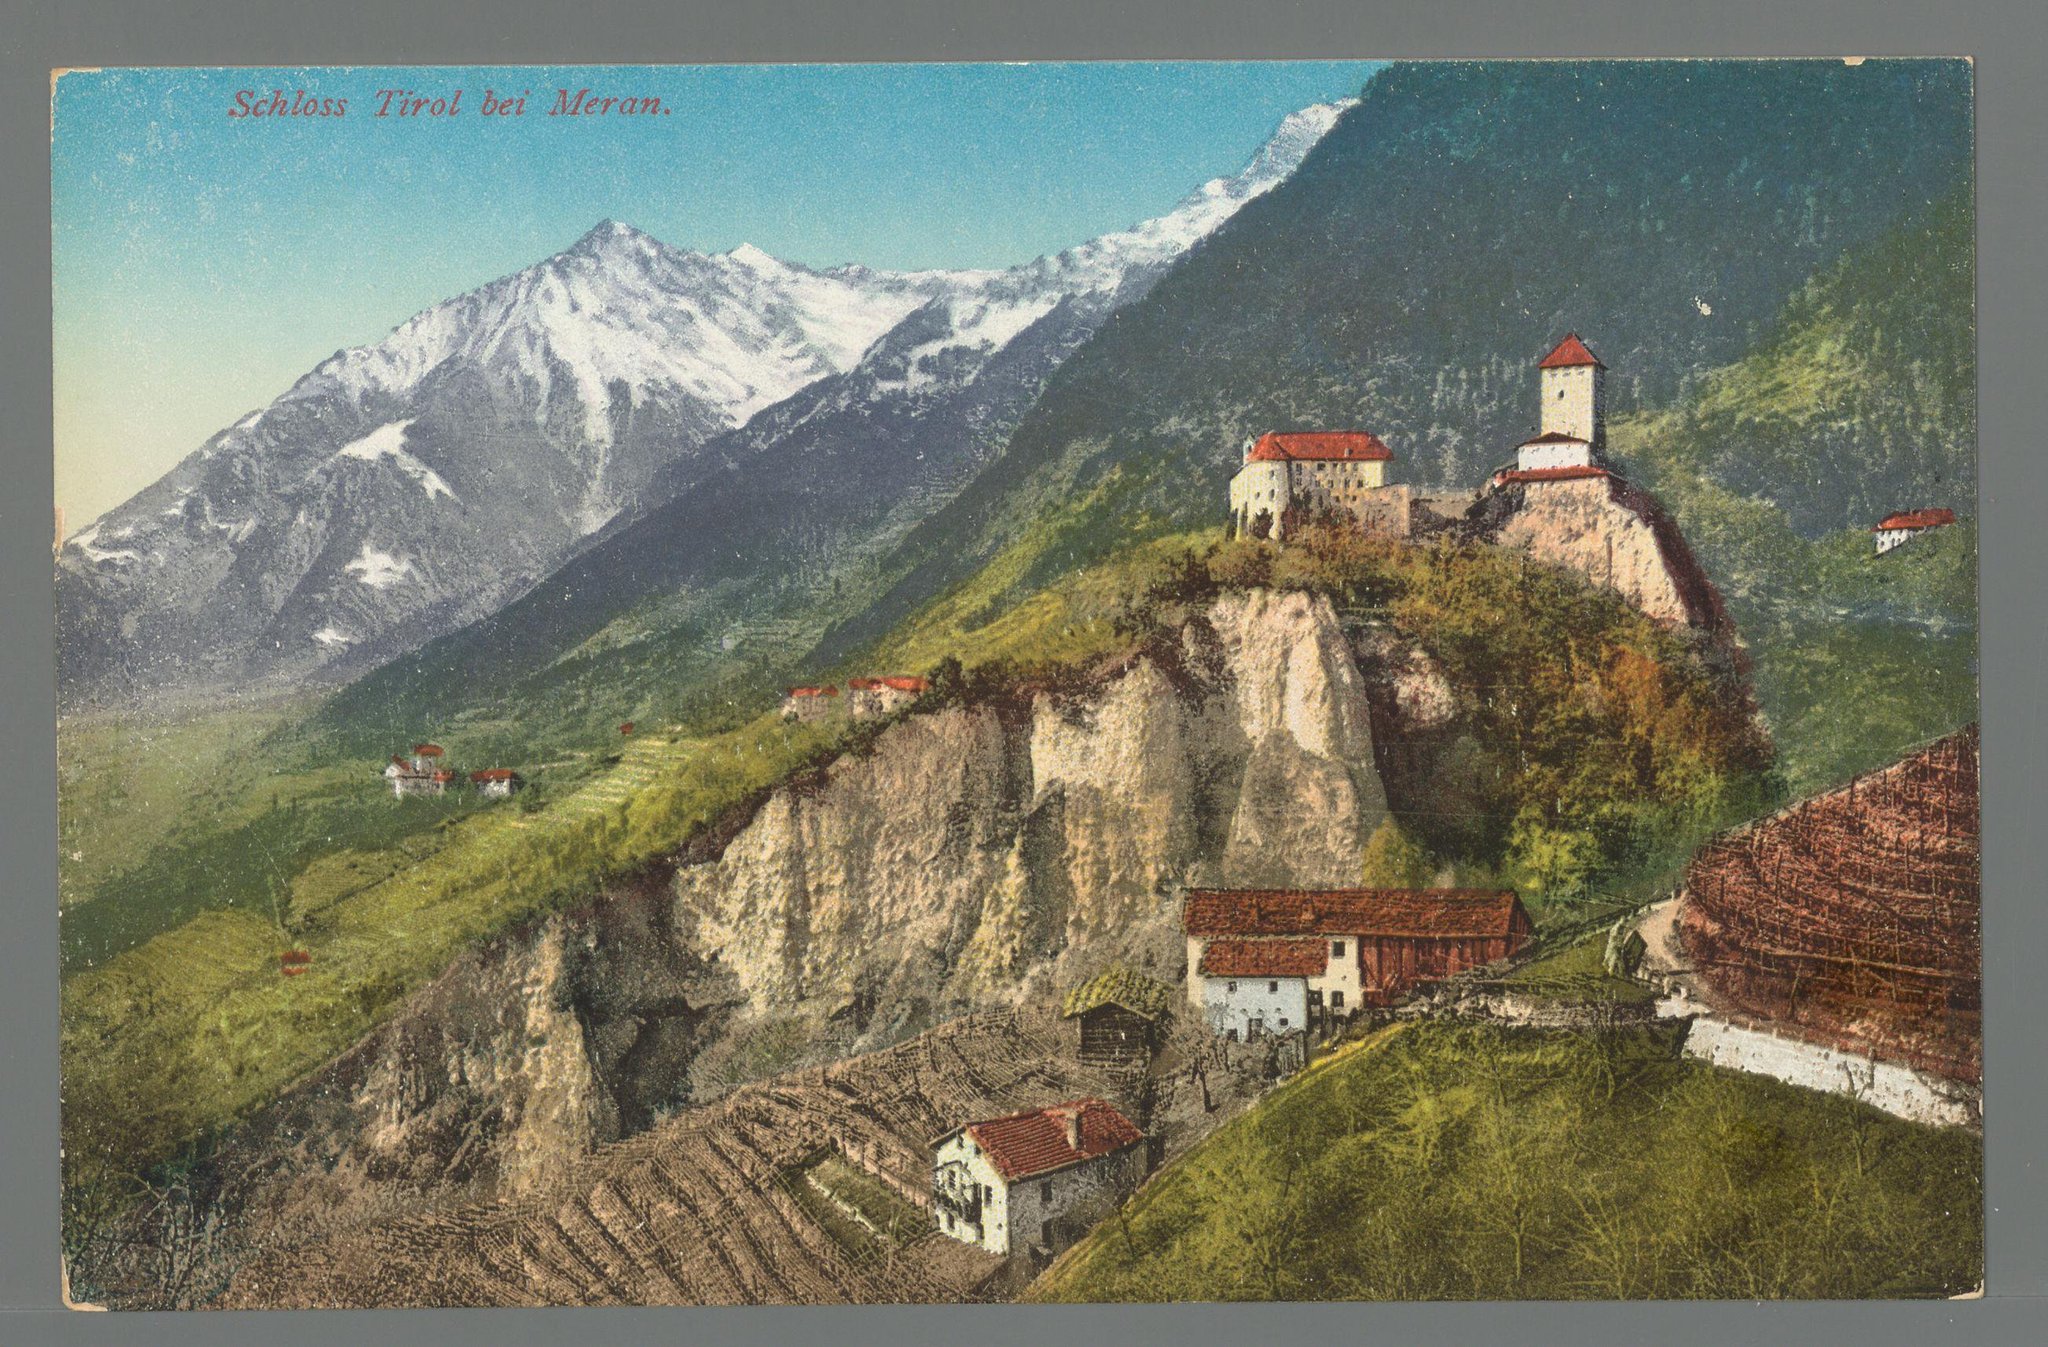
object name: photomechanical print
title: Schloss Tirol bei Meran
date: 1906-1930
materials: cardboard, photographic process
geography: merano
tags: landscape with tower or castle, mountains